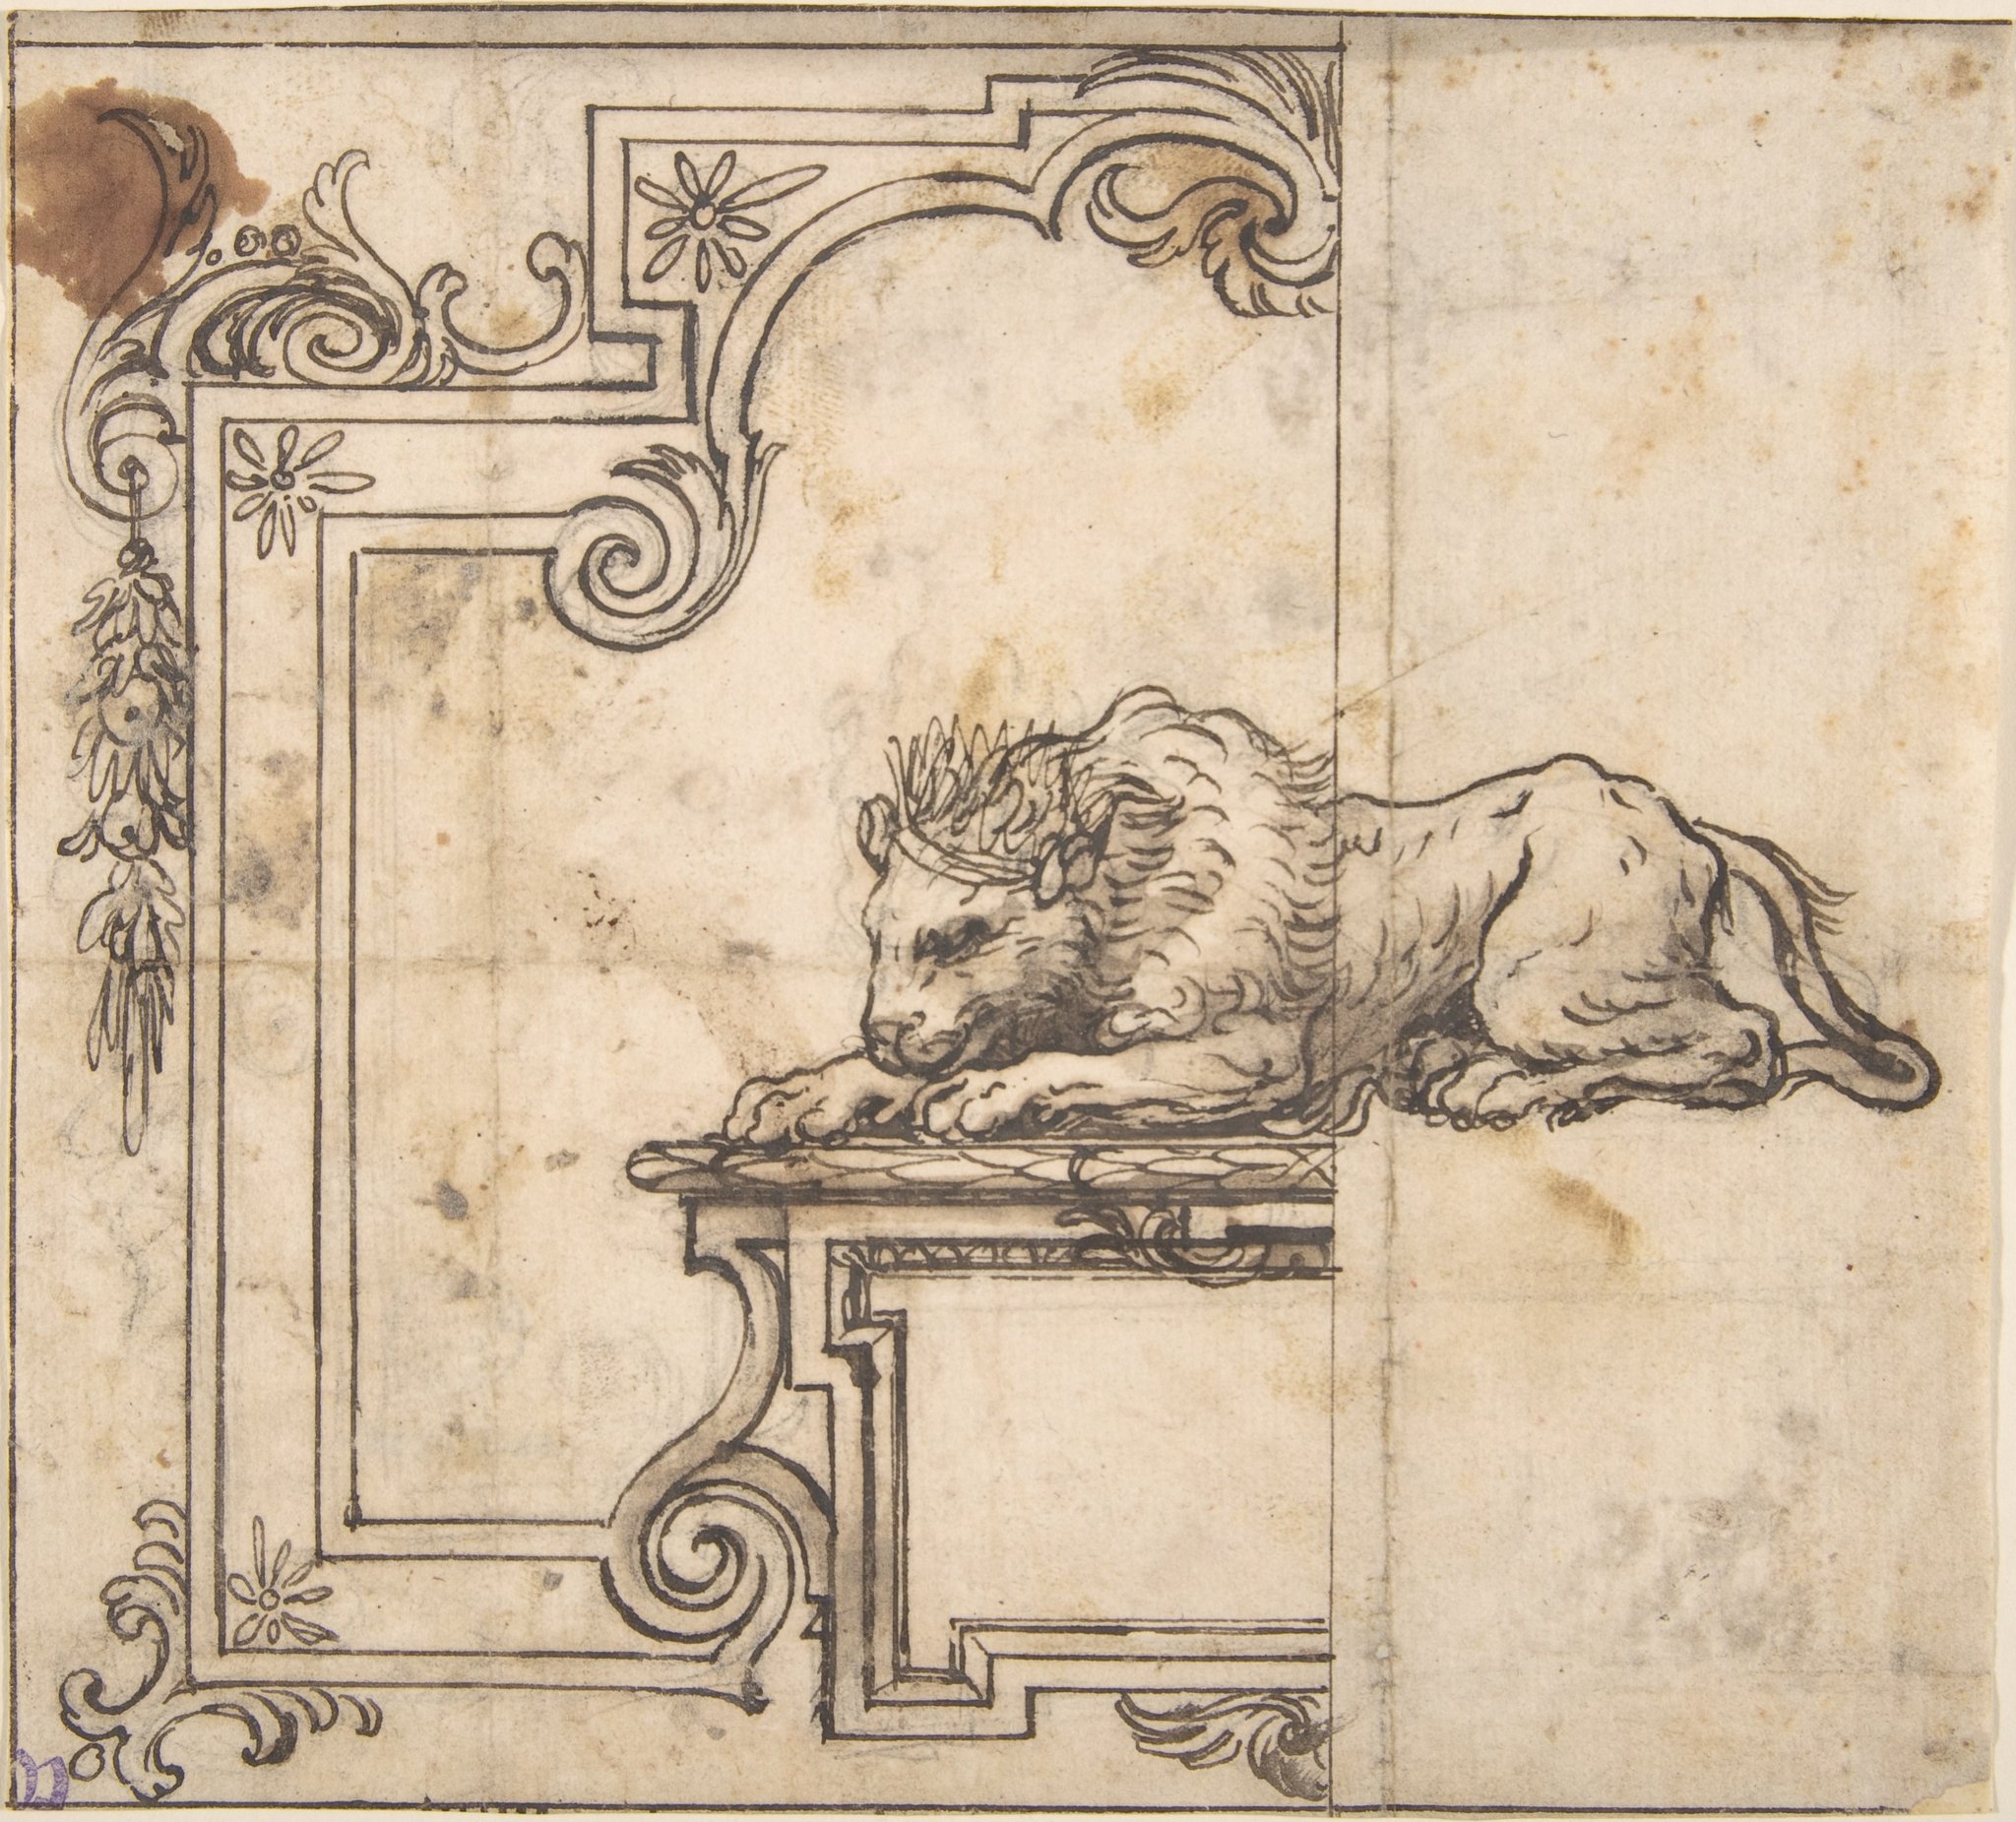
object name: drawing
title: Design for a Frame with Two Compartments and a Crowned Lion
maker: anonymous, italian, 17th century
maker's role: artist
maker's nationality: italian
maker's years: 1600-1700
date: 1601-1700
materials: graphite, ink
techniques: pen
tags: lions